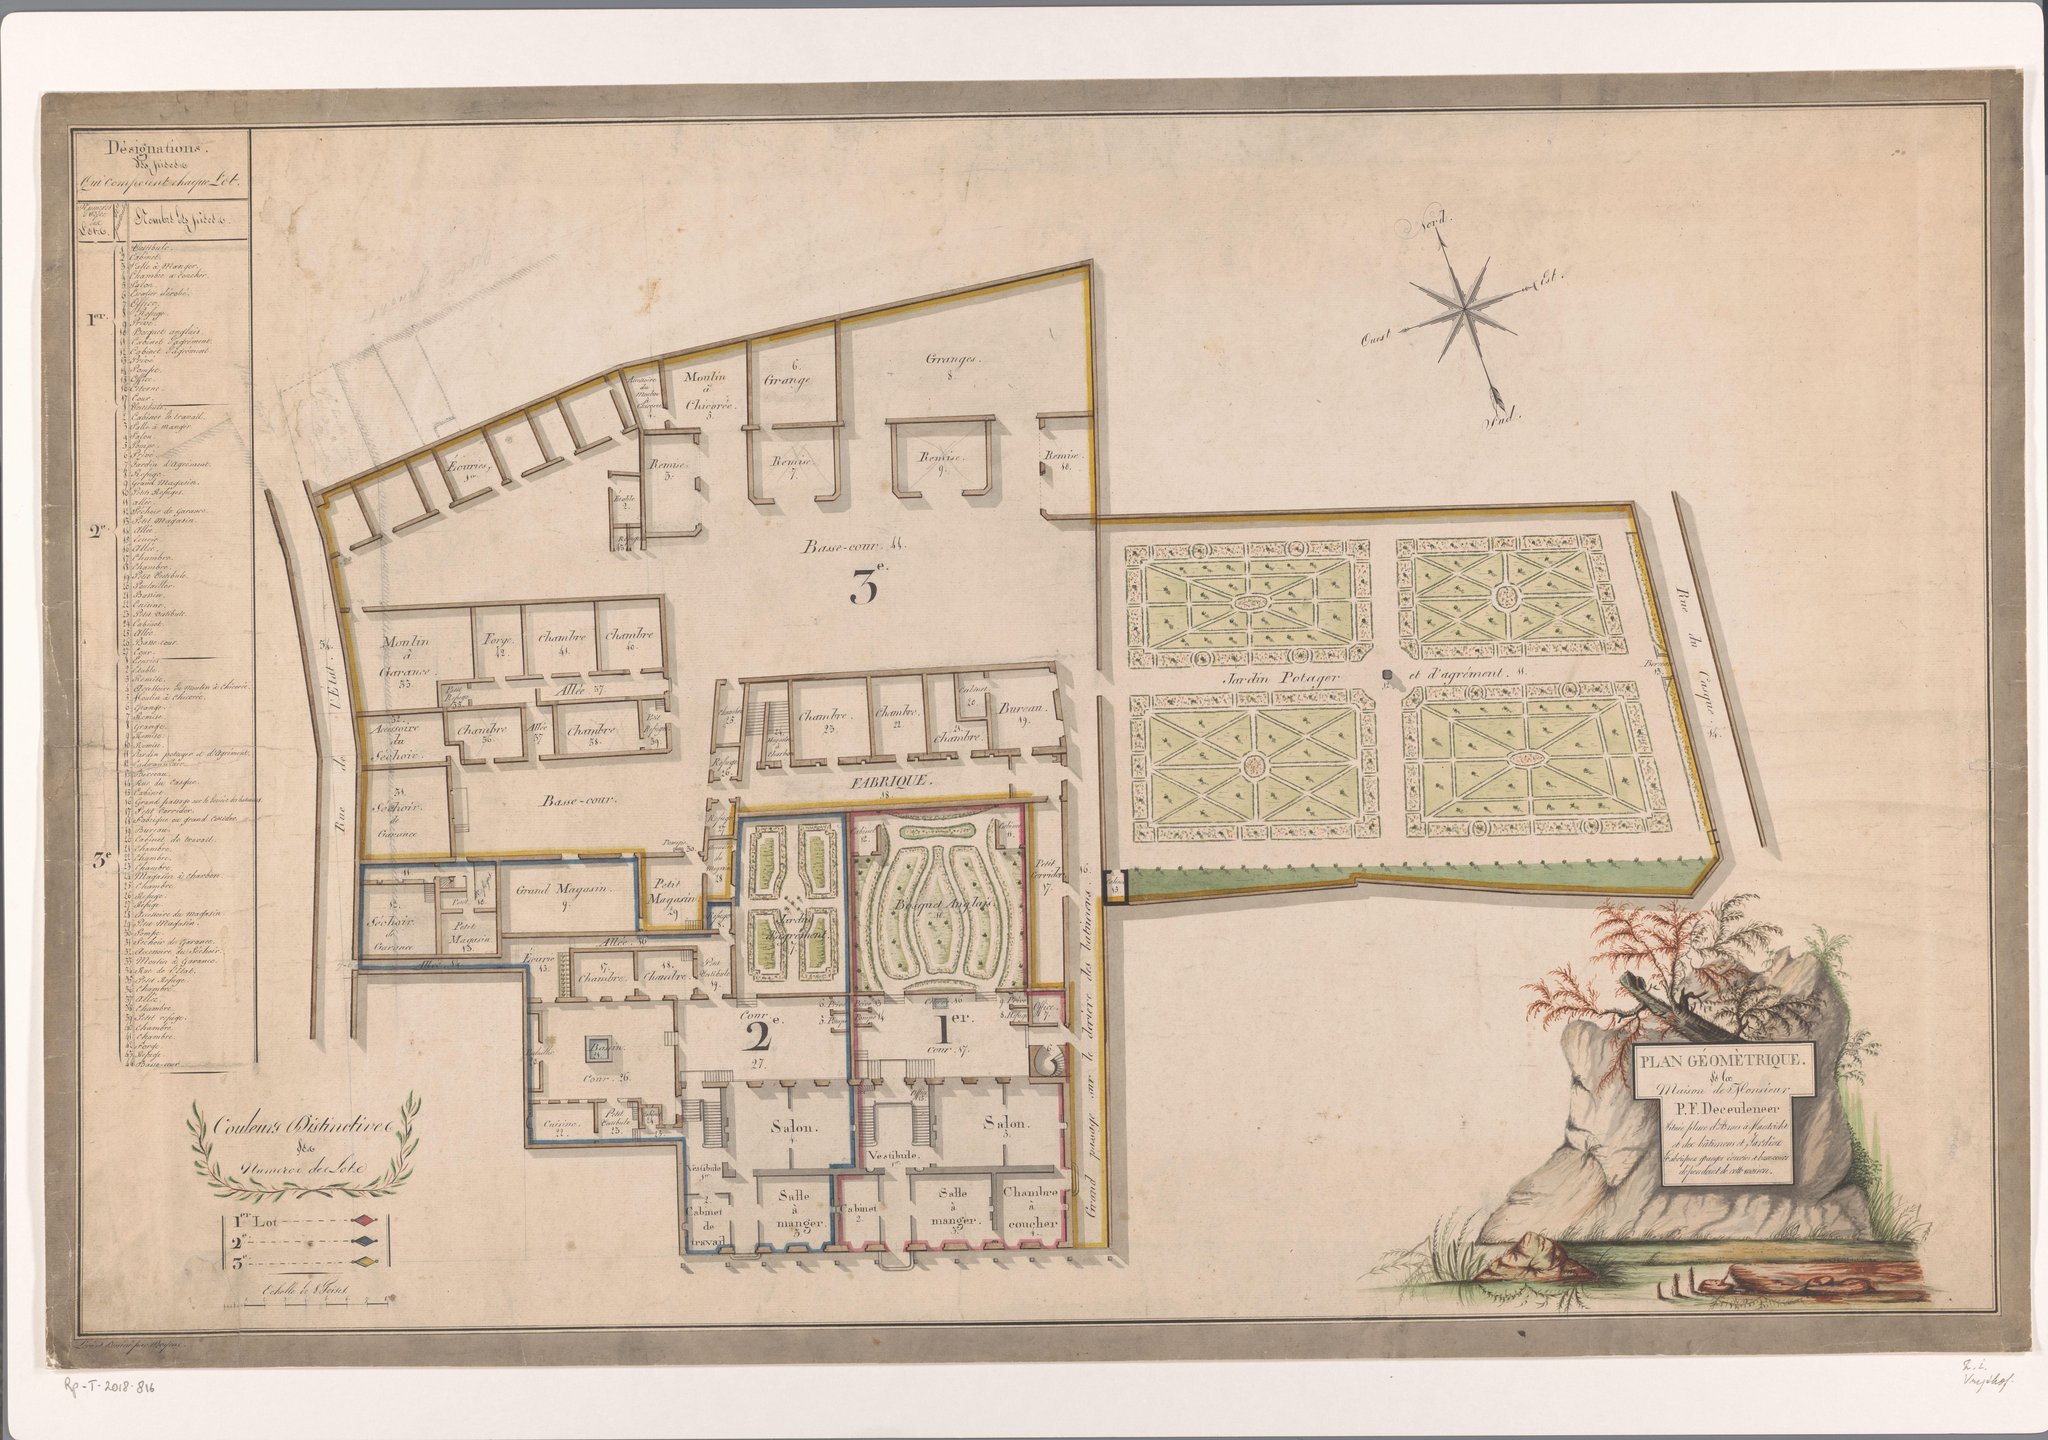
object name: area plan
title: Plattegrond van het Generaalshuis, te Maastricht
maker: Anonymous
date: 1803-1825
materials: ink, paper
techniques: brush, pen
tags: plan ~ architecture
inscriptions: inscription: ‘Levé et Dessiné par Bo[...]’, collector's mark: Lugt 2228